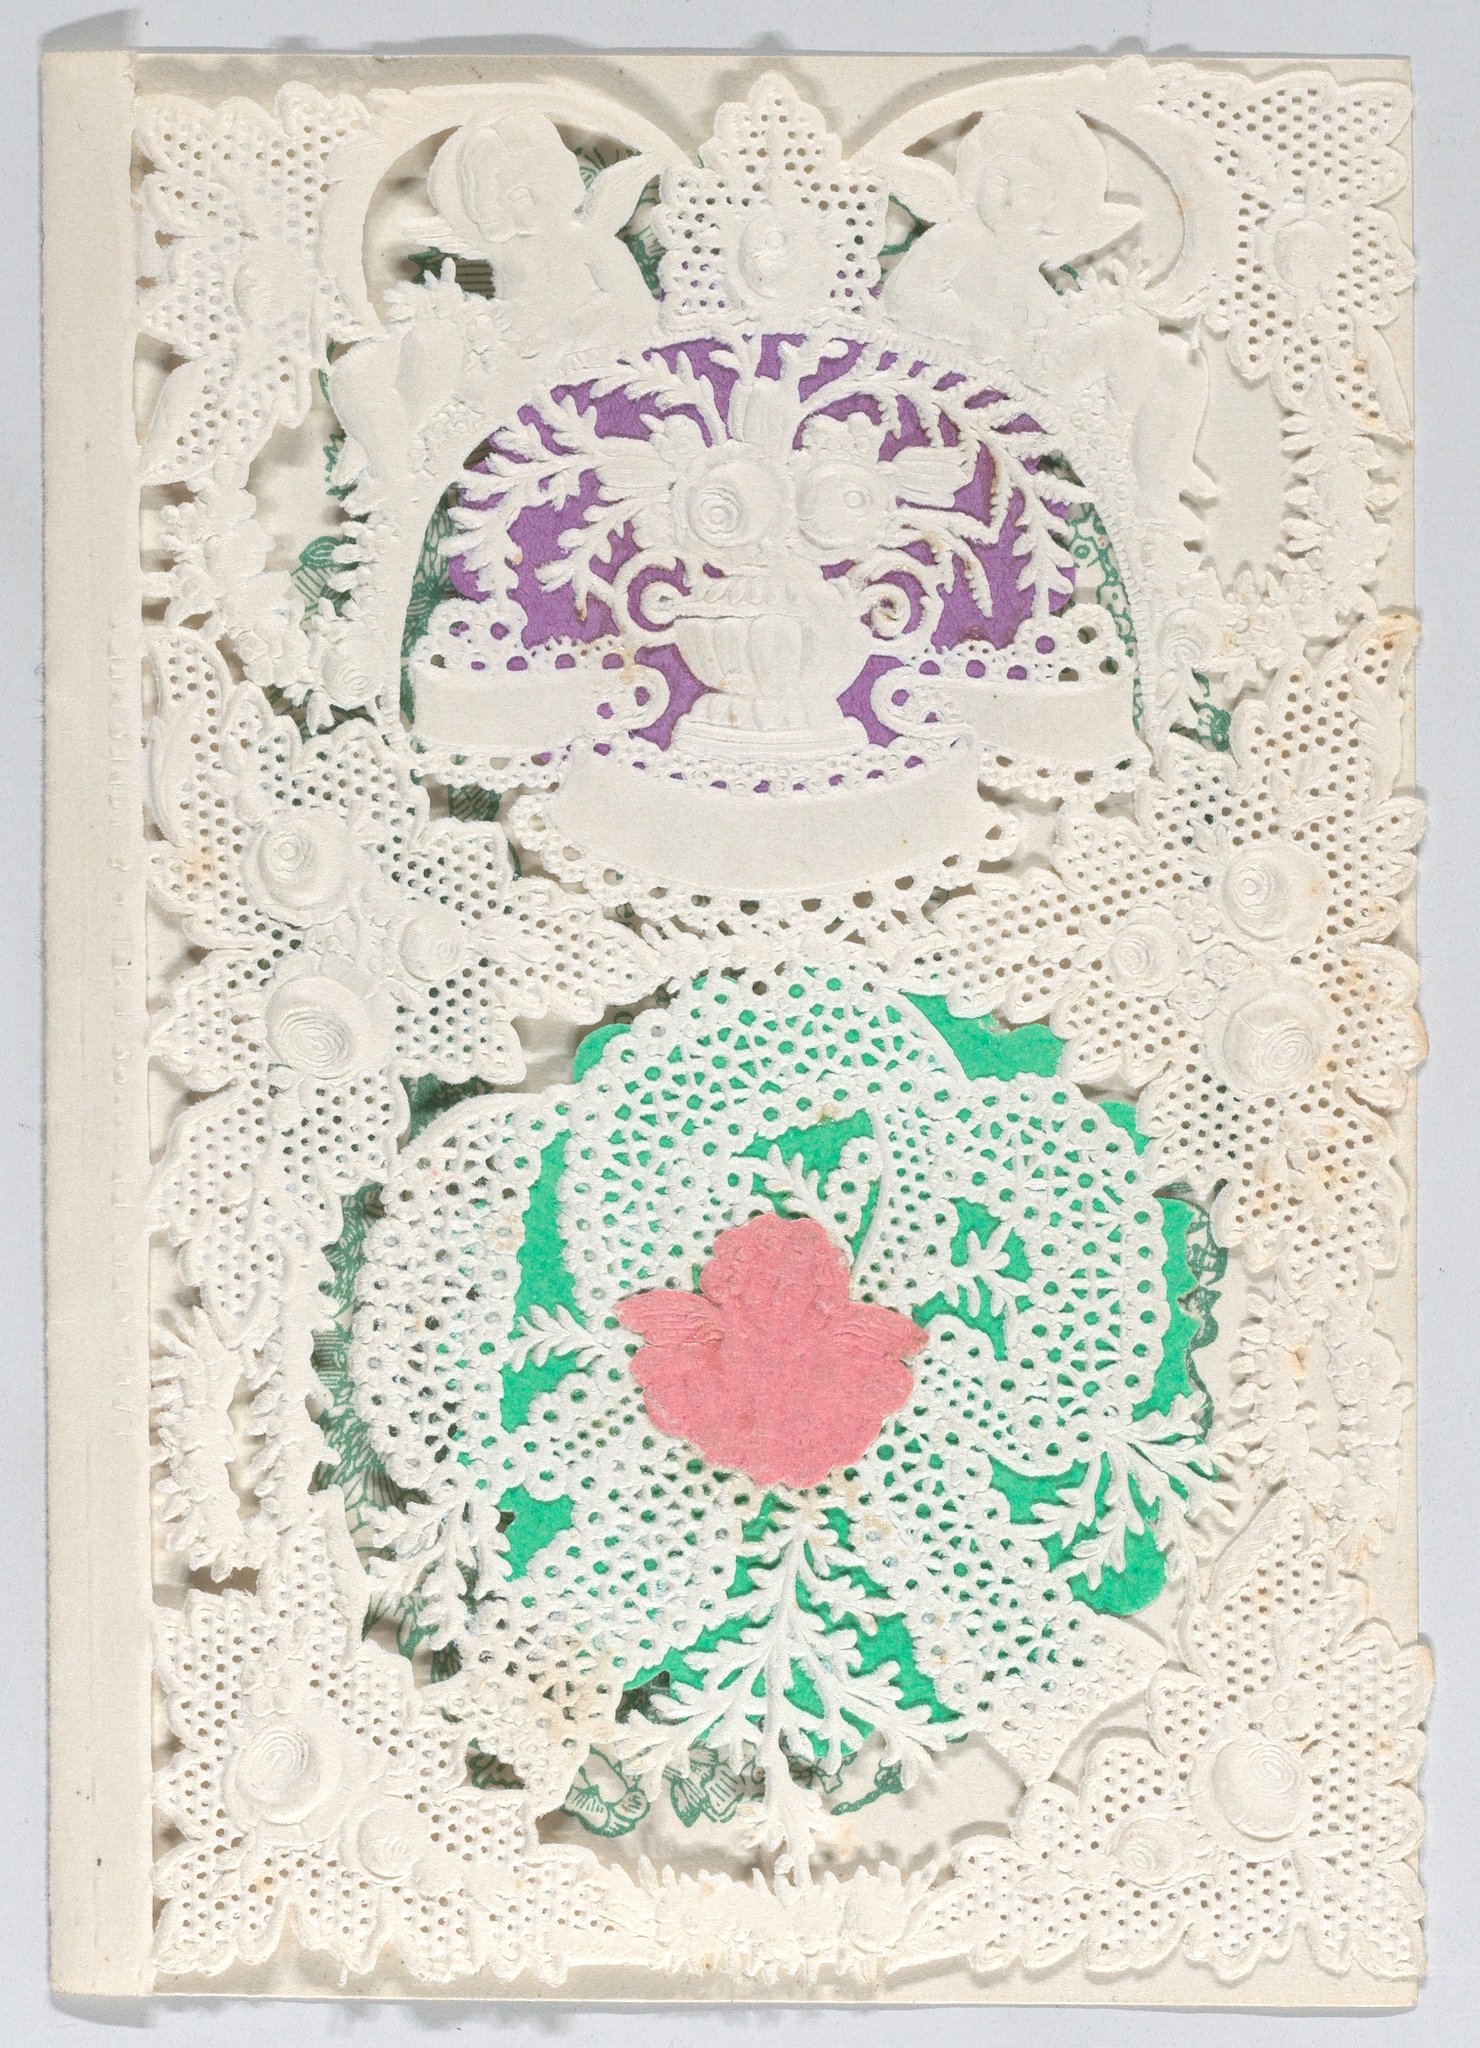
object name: valentine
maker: Anonymous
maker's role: artist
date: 1850-1870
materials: ink, lace, paper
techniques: embossing, open work